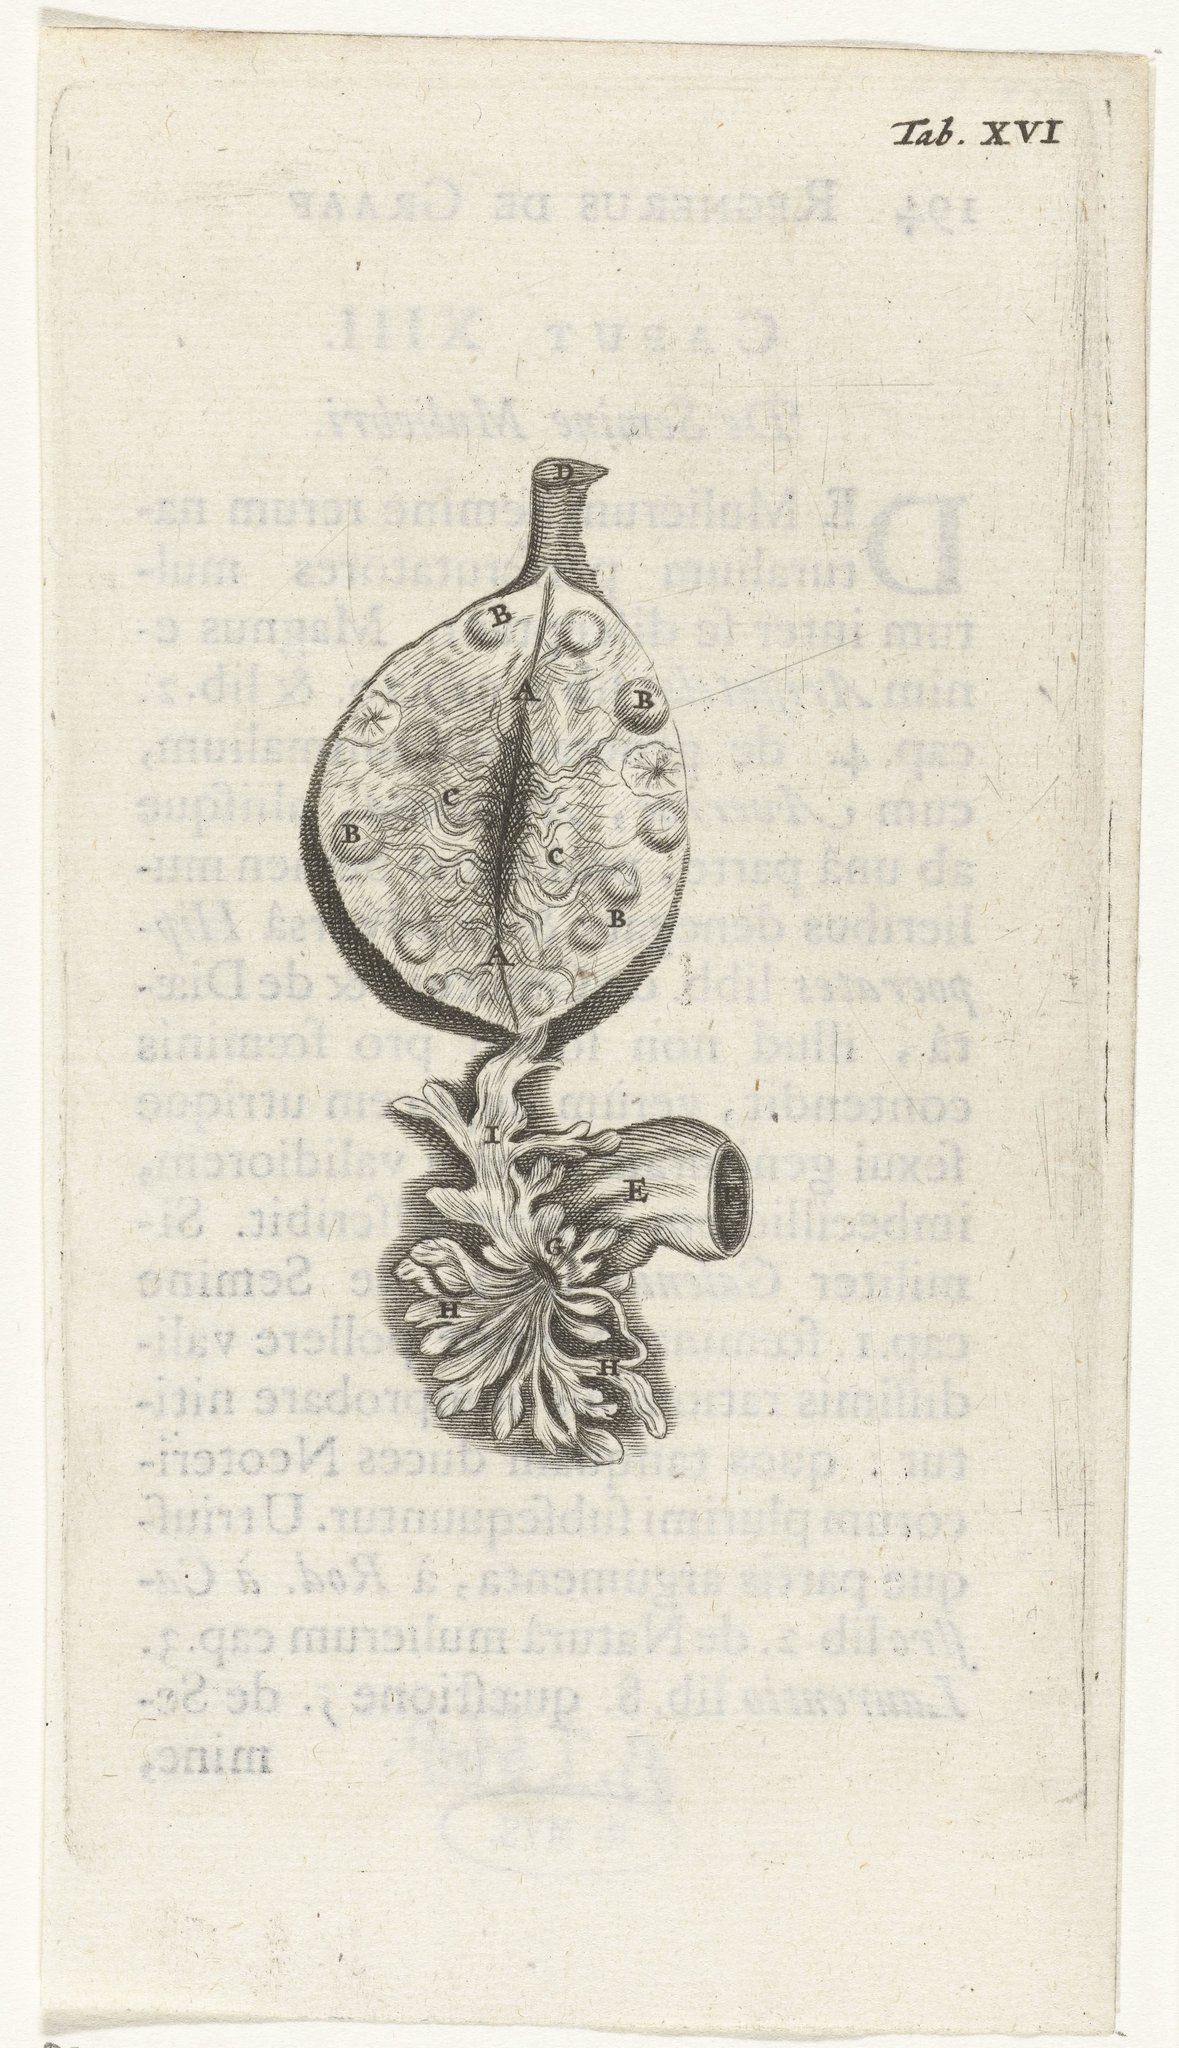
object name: print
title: Prints of the Female Reproductive Organs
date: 1672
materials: paper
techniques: engraving, letterpress printing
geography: netherlands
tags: ovaries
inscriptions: collector's mark: Lugt 2228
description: In 1672, physician and anatomist Reinier de Graaf published his De mulierum organis about the female reproductive organs. The book contains detailed prints by Hendrik Bary, among them several of the vagina. De Graaf was the first to conclude that a foetus was the product not just of a man’s seed, but also of a woman’s egg. He discovered what he called blisters, which later became known as Graafian follicles.